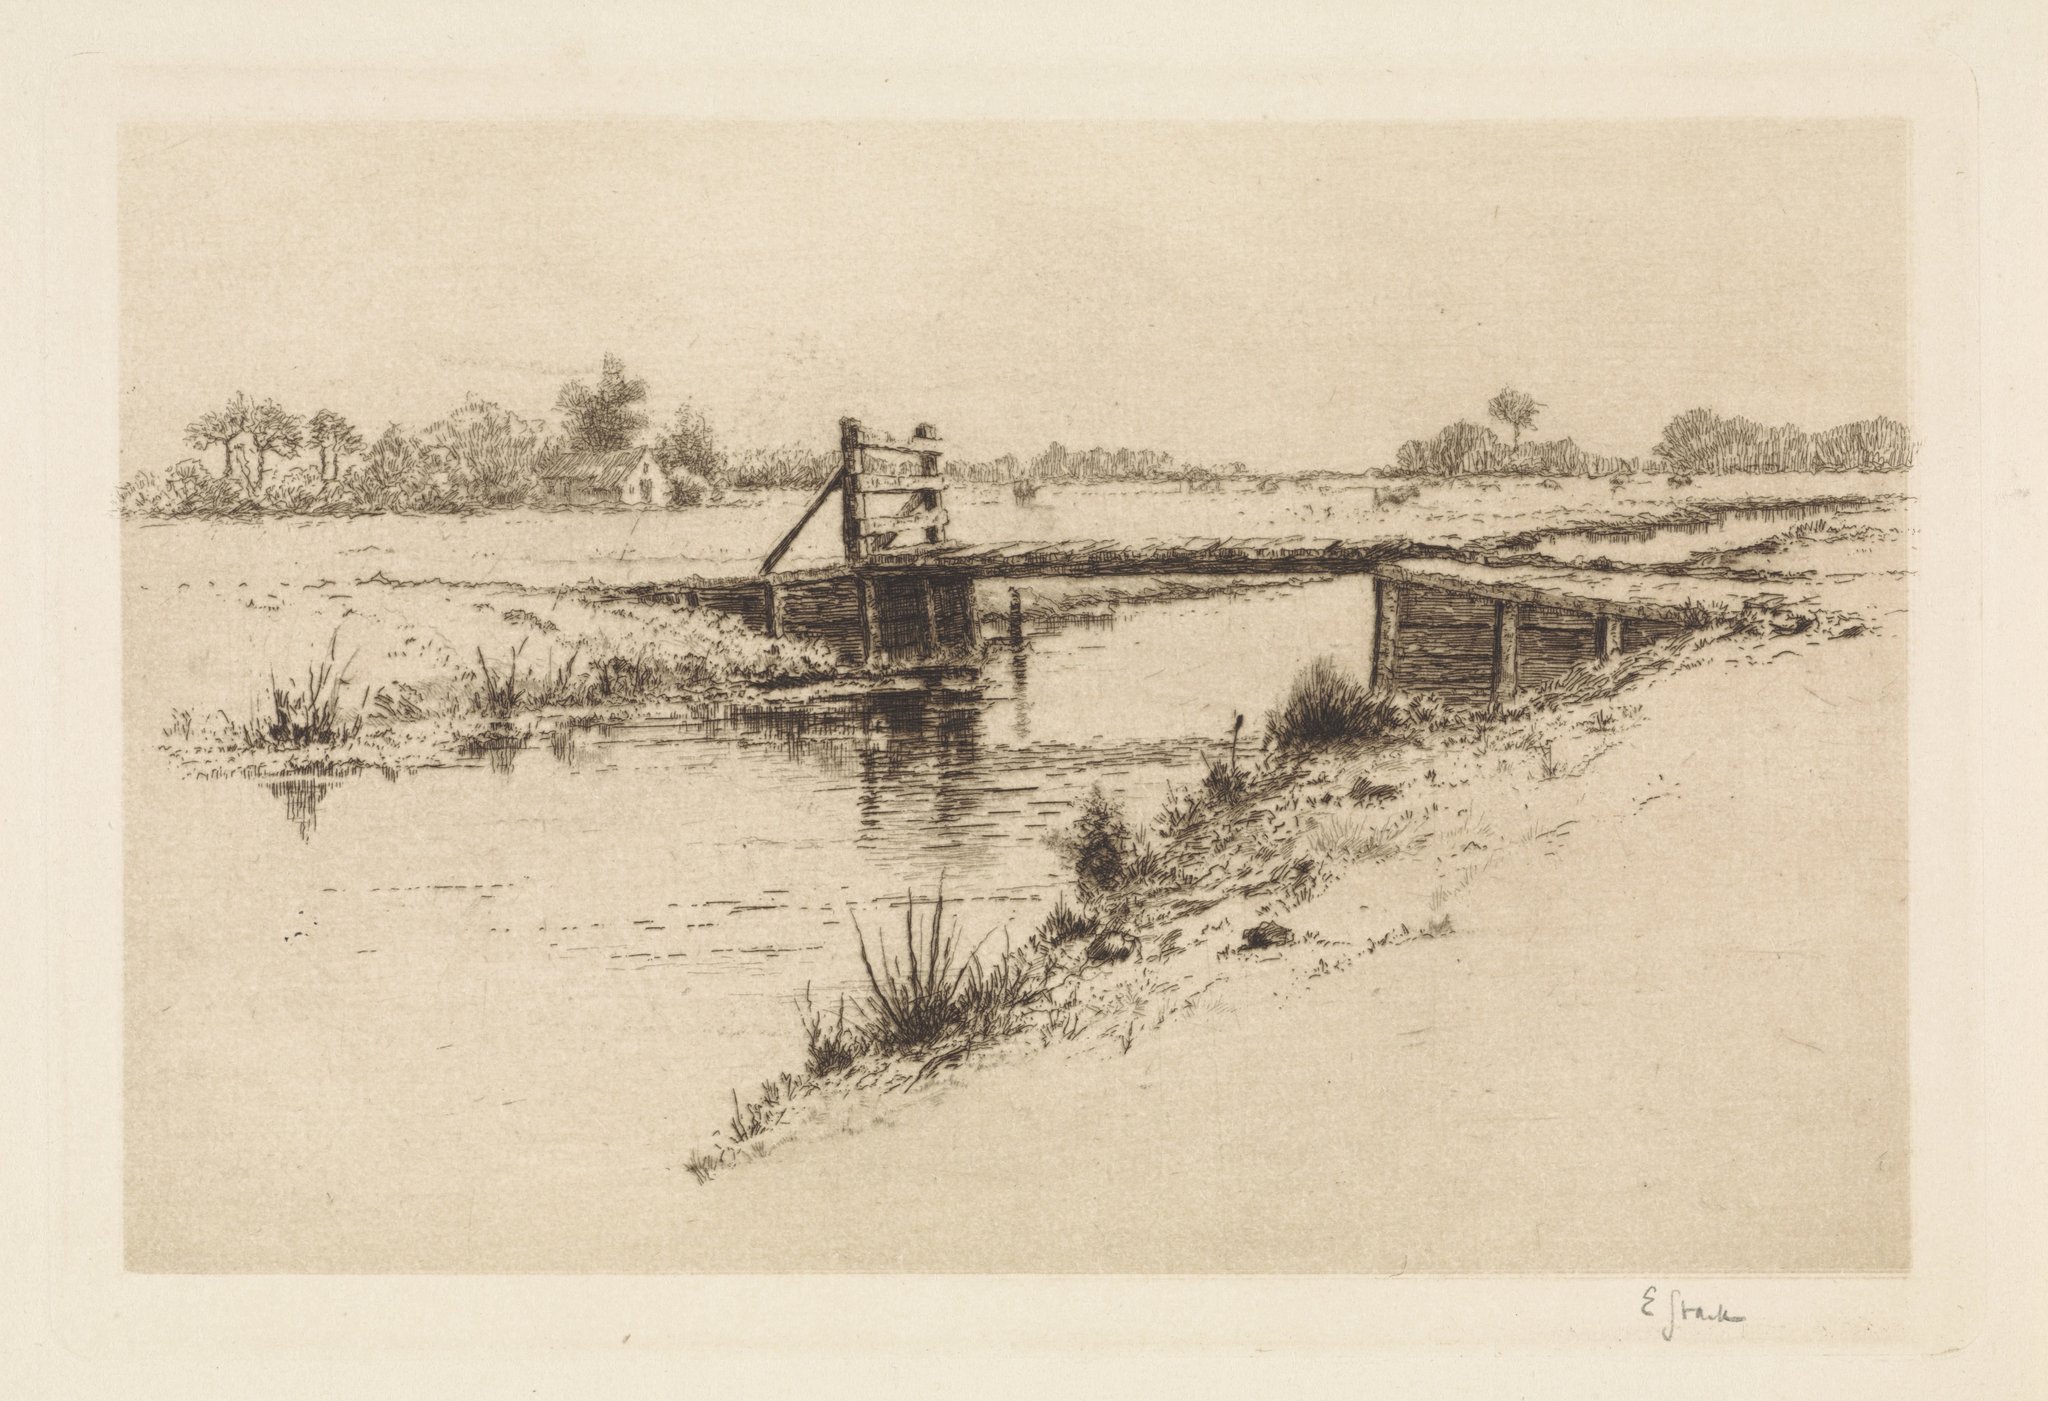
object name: print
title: Bruggetje over een sloot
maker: elias stark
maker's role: draughtsman, print maker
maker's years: 1849-1933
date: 1859-1908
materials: paper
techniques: etching, intaglio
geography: netherlands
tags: water course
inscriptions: collector's mark: Lugt 2228